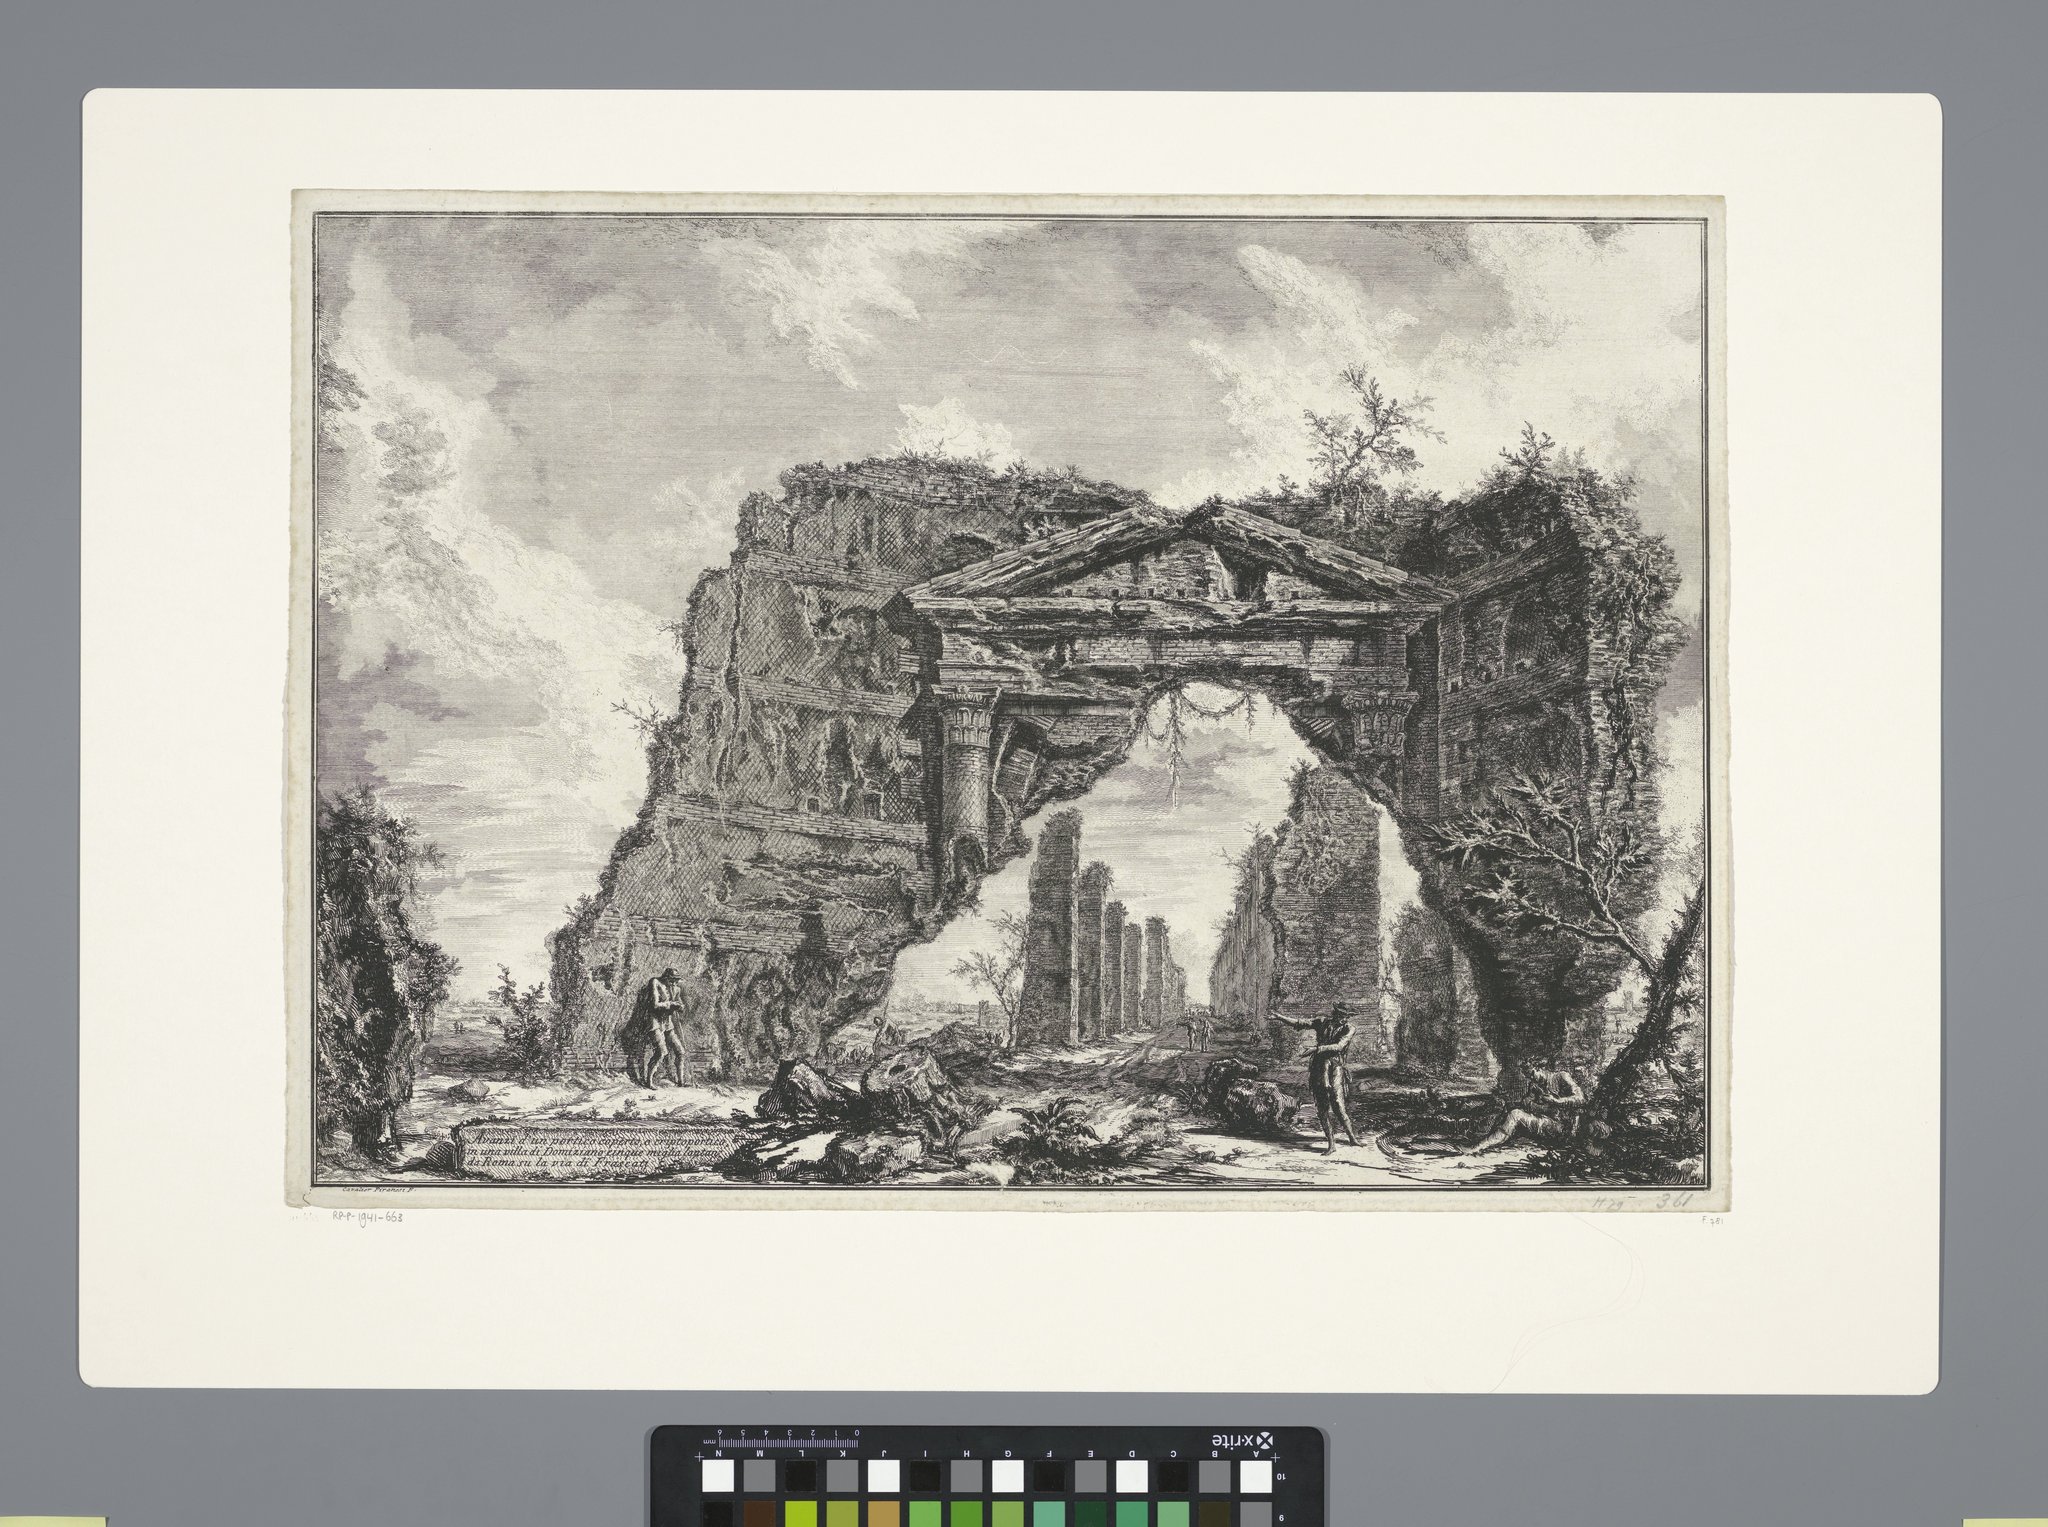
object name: print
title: Vedute di Roma disegnate ed incise da Giambattista Piranesi architetto Ve(nez)iano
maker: giovanni battista piranesi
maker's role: designer, draughtsman, print maker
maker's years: 1720-1778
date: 1748-1778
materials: paper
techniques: etching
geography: rome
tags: city-view, and landscape with man-made constructions, ruin of a building ~ architecture, landscape with ruins, gate, entrance, rome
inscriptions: collector's mark: Lugt 2228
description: Deze prent maakt deel uit van de serie 'Vedute di Roma'. Piranesi werkte aan deze 135 platen tellende serie tussen 1748 en zijn dood in 1778. Francesco Piranesi voegde later nog twee prenten toe aan de reeks van zijn vader.